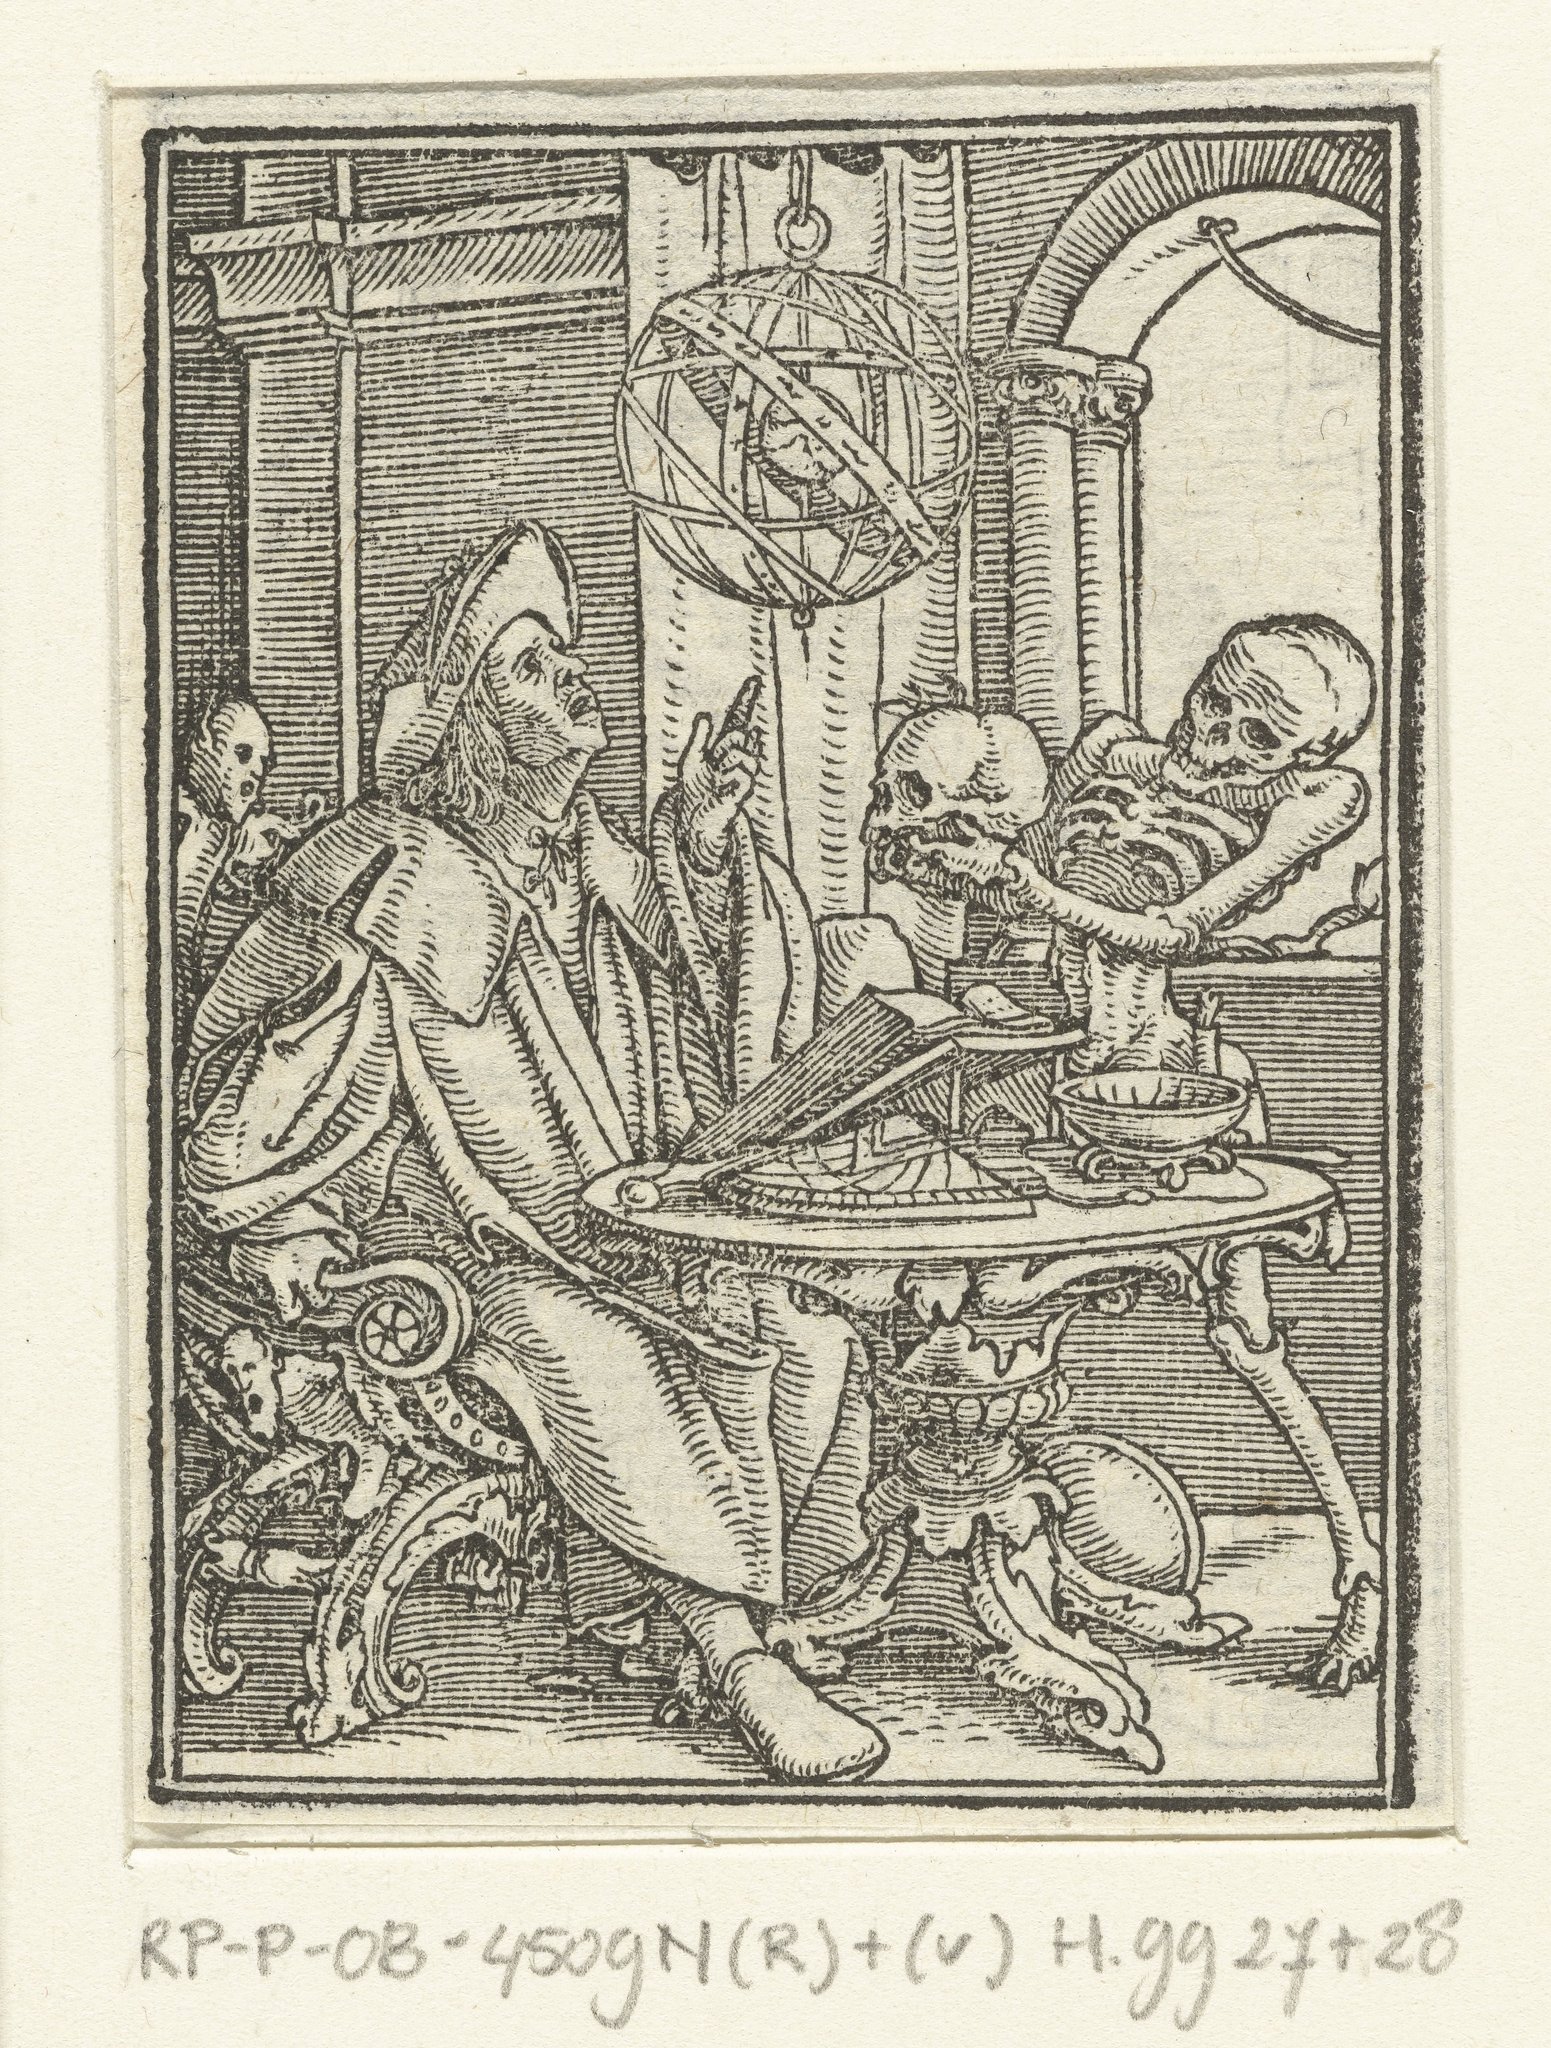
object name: book illustration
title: Astronoom en de Dood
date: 1524-1526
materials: paper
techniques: woodcut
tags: astronomical instruments, dance of death; death together with one or more human beings, astronomy (and cosmography) (+ scholar, scientist (at work))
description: De houtblokken werden voor 1526 vervaardigd door Hans Lützelburg en pas in 1538 voor het eerst gebruikt als boekillustraties in: Les simulachres & historiees faces de la mort avtant elegamment pourtraictes que artificiellement imaginées... a Lyon, Soubsz l'escu de Coloigne, MDXXXVIII, (M. en G. Trechsel, voor F. Frellon in Lyon), 1538. Later verschenen nog andere uitgaven.